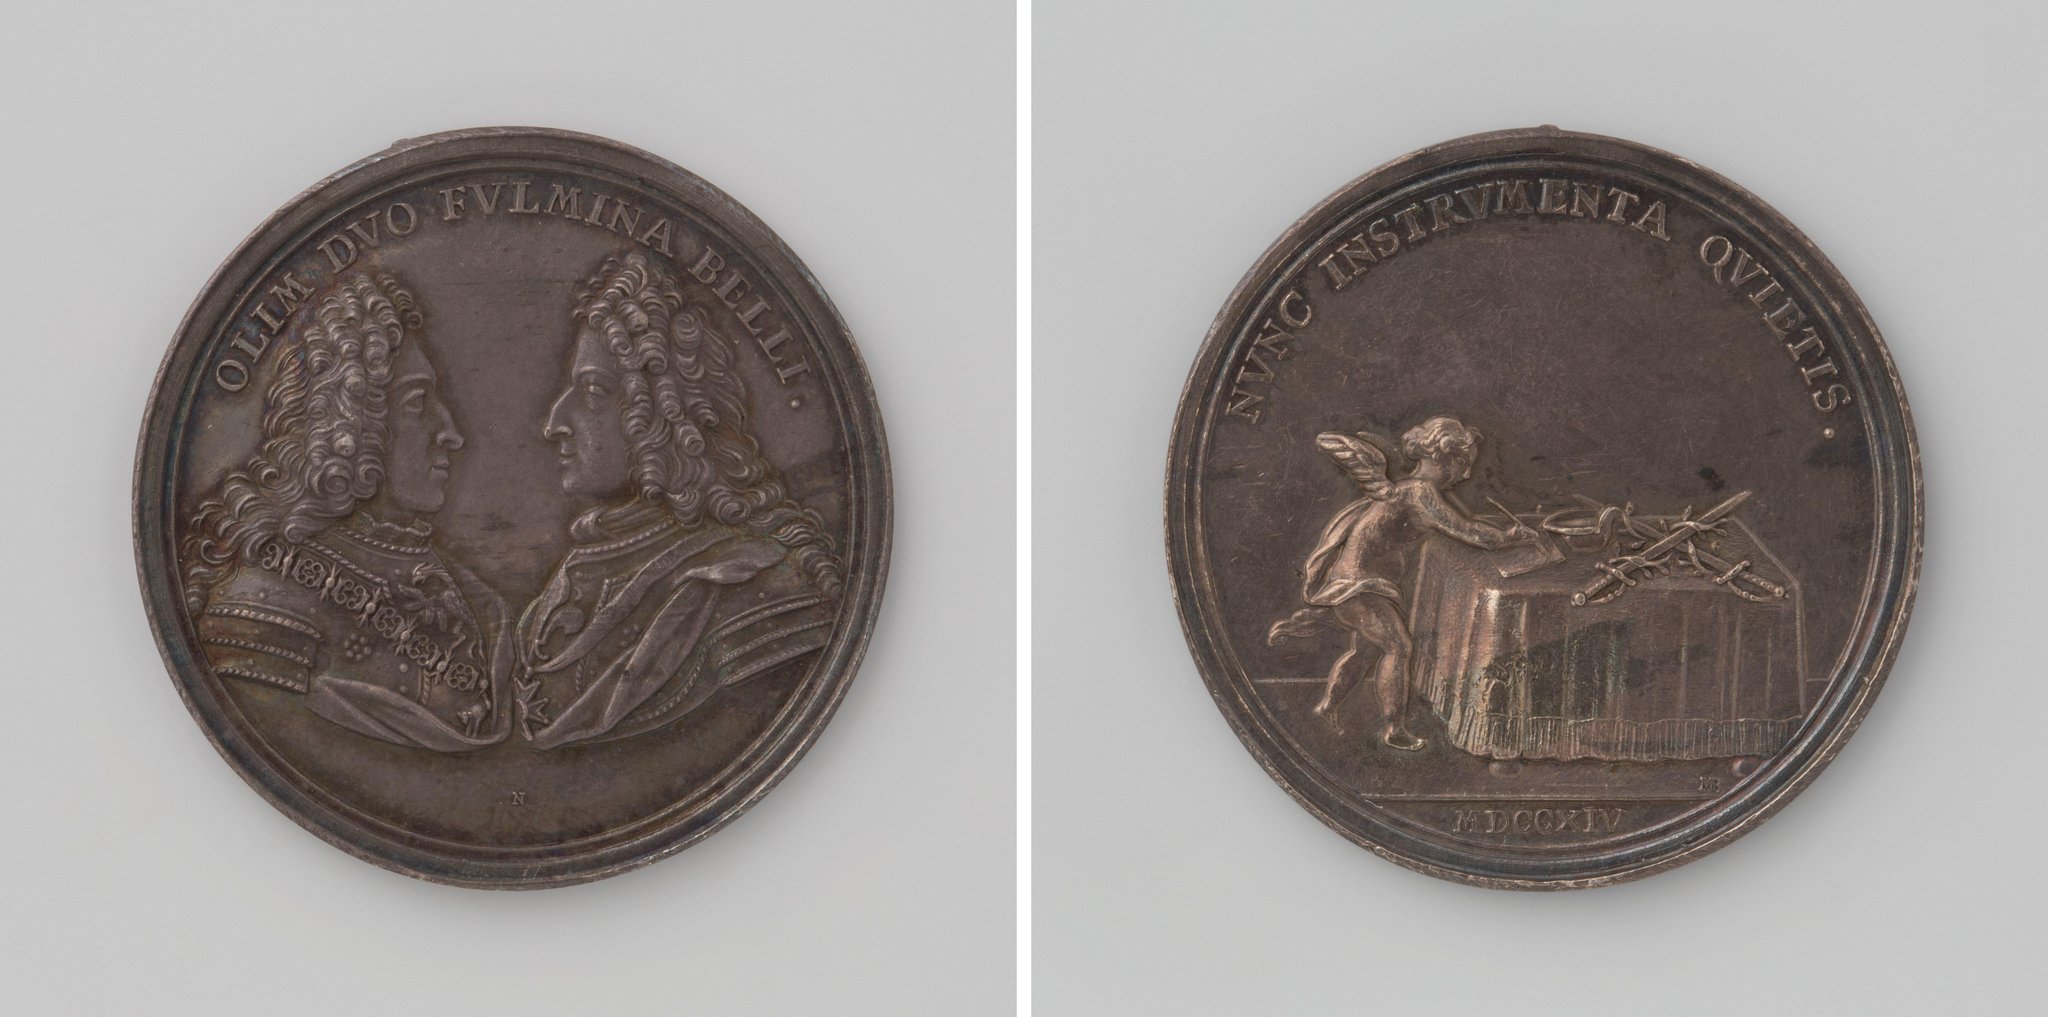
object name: history medal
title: Vrede van Rastatt, ter ere van Eugenius van Savoye en de hertog van Villars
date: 1714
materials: silver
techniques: striking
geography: nuremberg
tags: paris, vienna, eugenius van savoye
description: Zilveren penning. Voorzijde: naar elkaar gewende borststukken van twee mannen binnen omschrift. Keerzijde: engeltje schrijft op stuk papier liggend op tafel naast paar met olijftakken omwonden zwaarden binnen omschrift; afsnede: jaartal